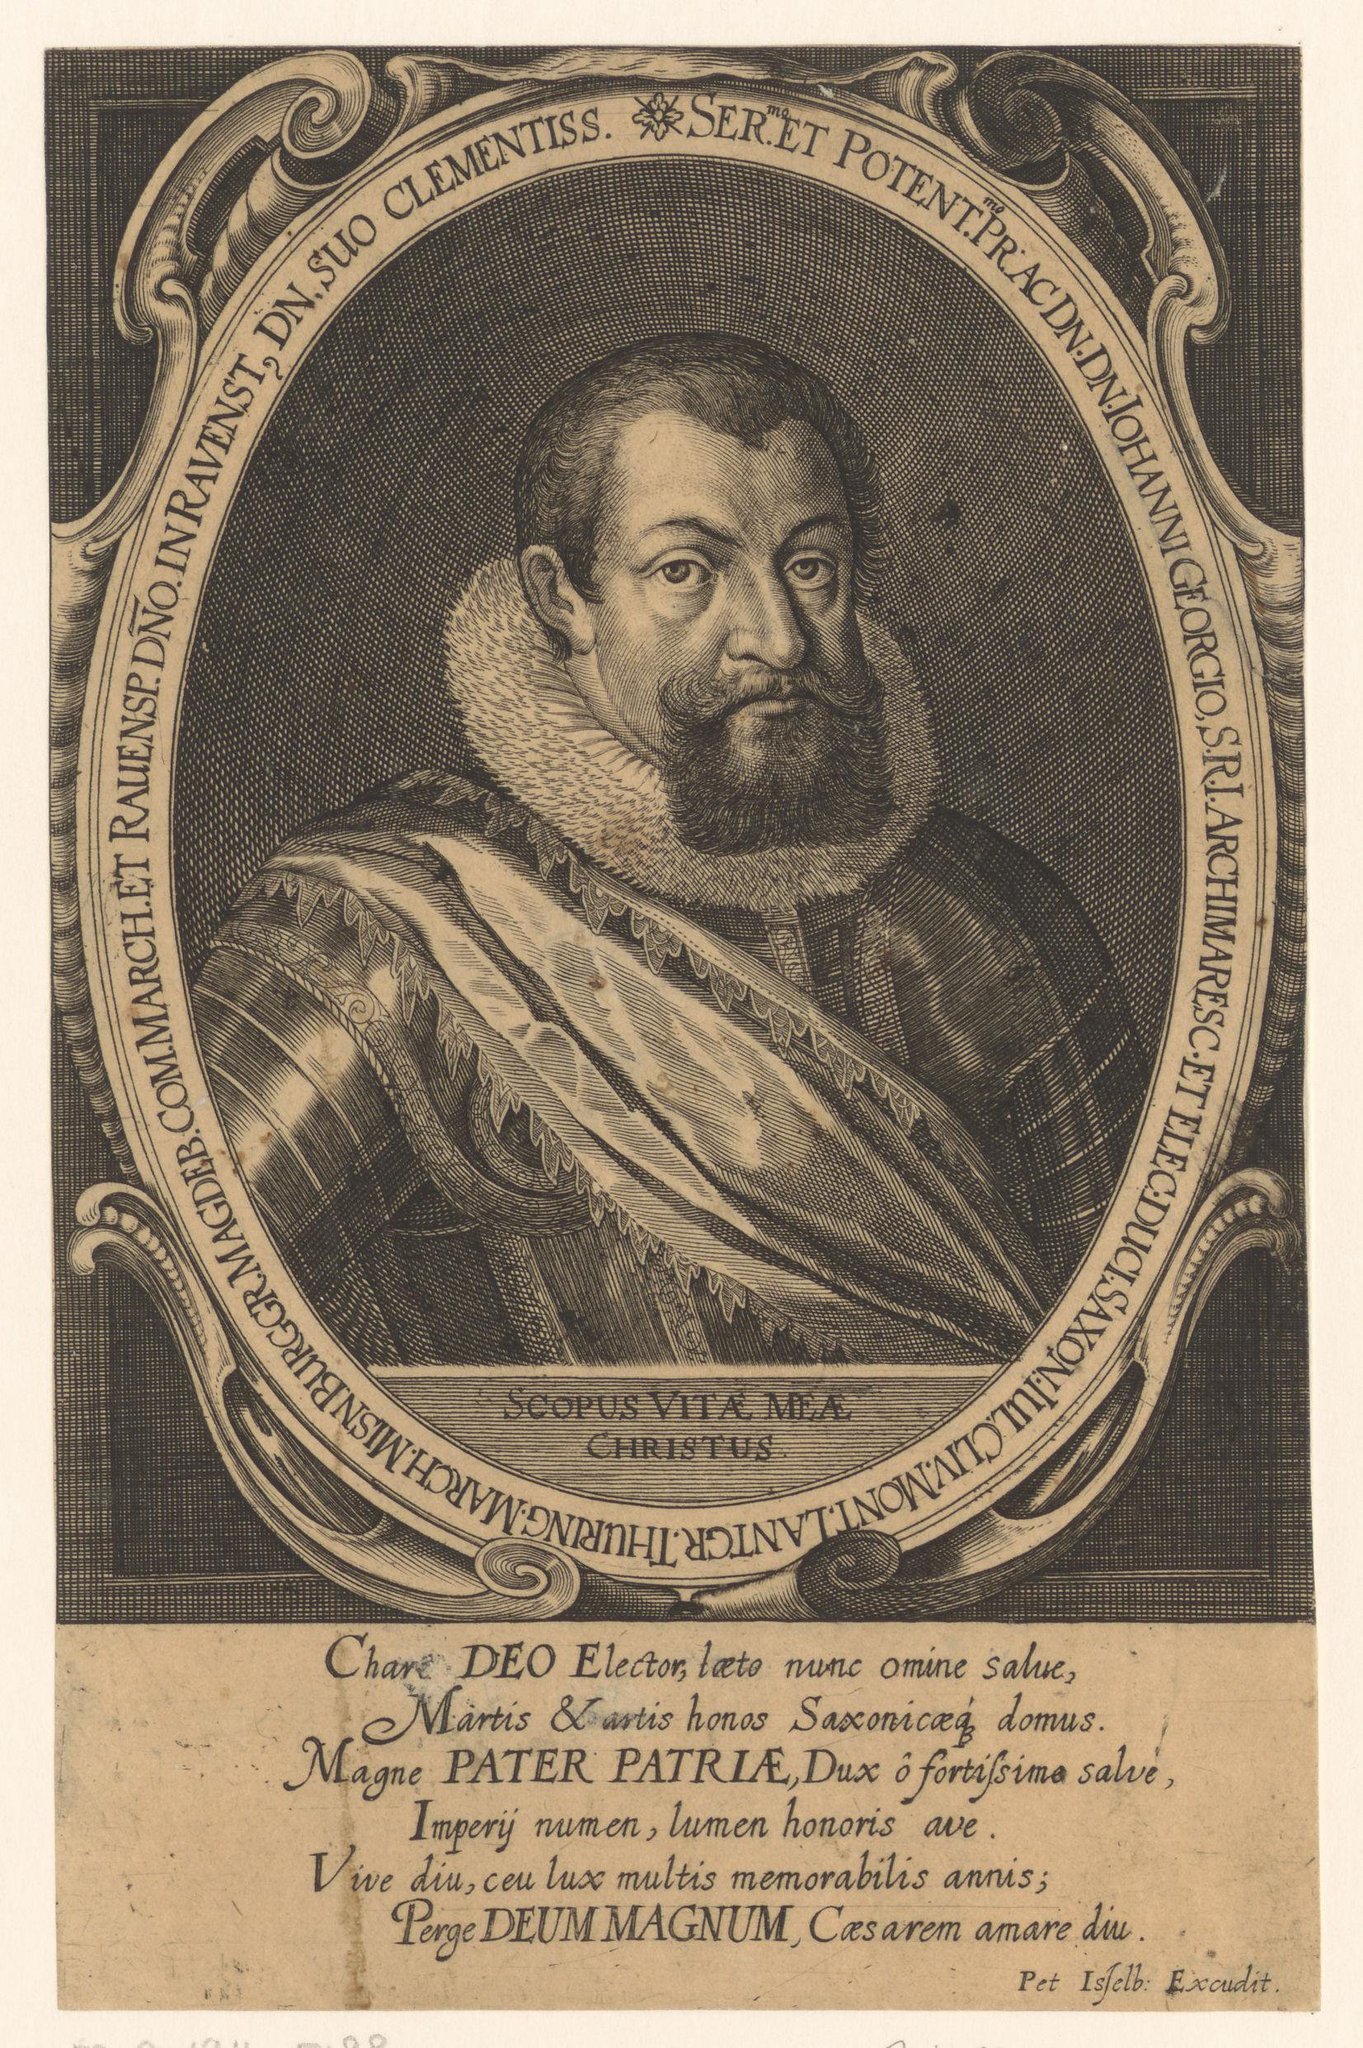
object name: print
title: Portret van Johann Georg I van Saksen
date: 1595-1678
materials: paper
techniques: engraving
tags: johann george van saksen (i), historical persons, politician, e.g. party leader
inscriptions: collector's mark: Lugt 2228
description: Tekst in het Latijn in de omlijsting en in de marge.